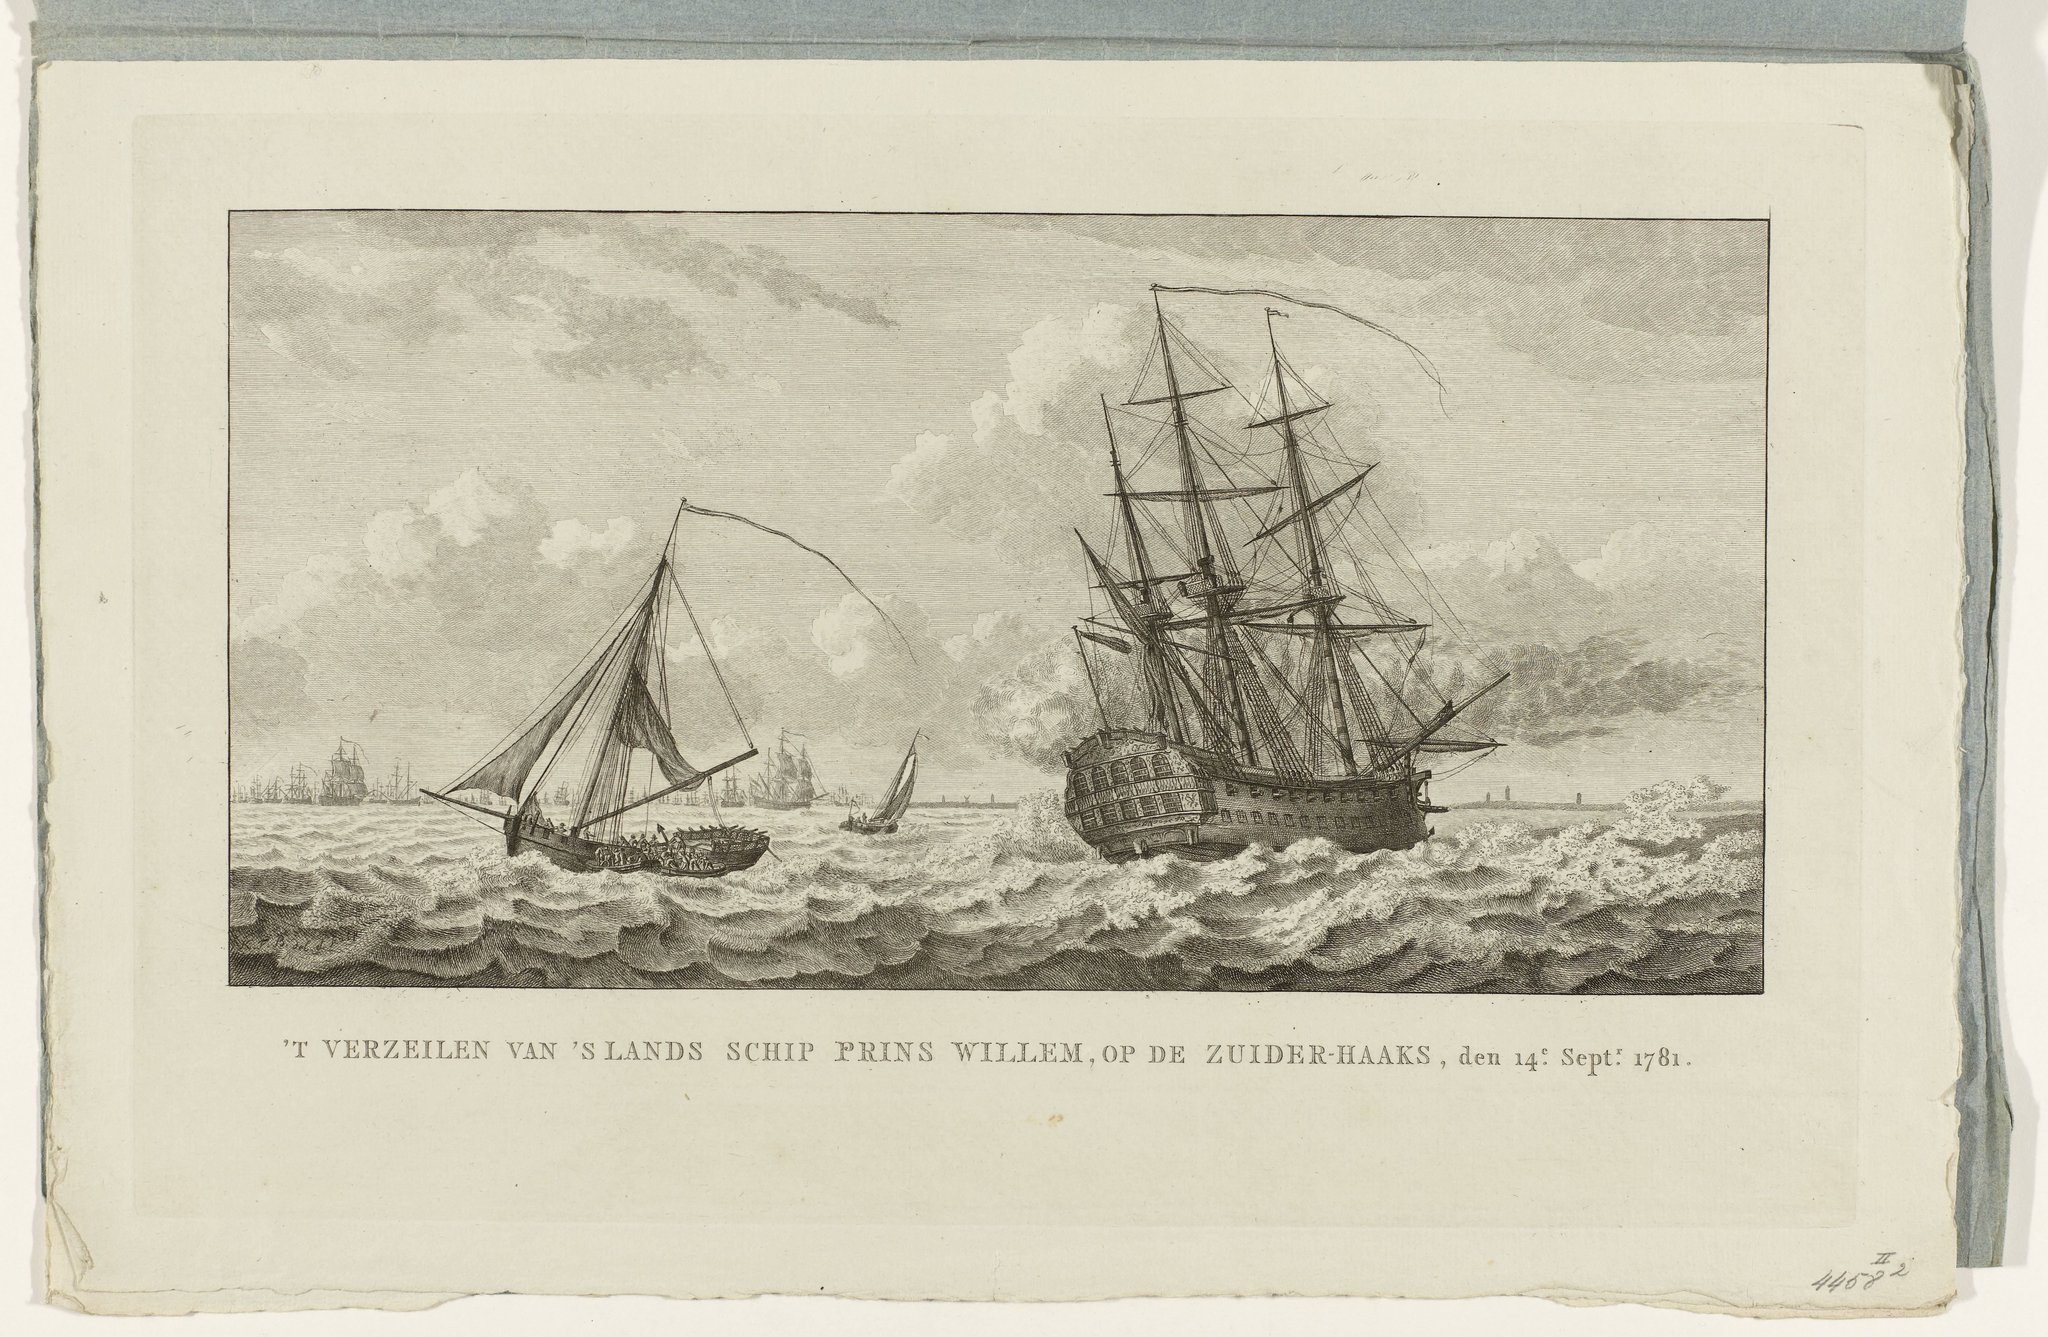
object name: print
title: Map met vier platen van historische gebeurtenissen ter zee in de jaren 1781-1784, tweede serie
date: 1784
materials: paper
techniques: engraving, etching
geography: amsterdam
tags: shipwreck (+ propulsion of vehicle, ship, etc. by wind)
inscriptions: collector's mark: Lugt 2228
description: Het aan de grond lopen van het schip Prins Willem op de Zuiderhaaks op 14 september 1781. Losse prent in de map met vier prenten van historische gebeurtenissen op zee in de jaren 1781-1784, tweede serie.